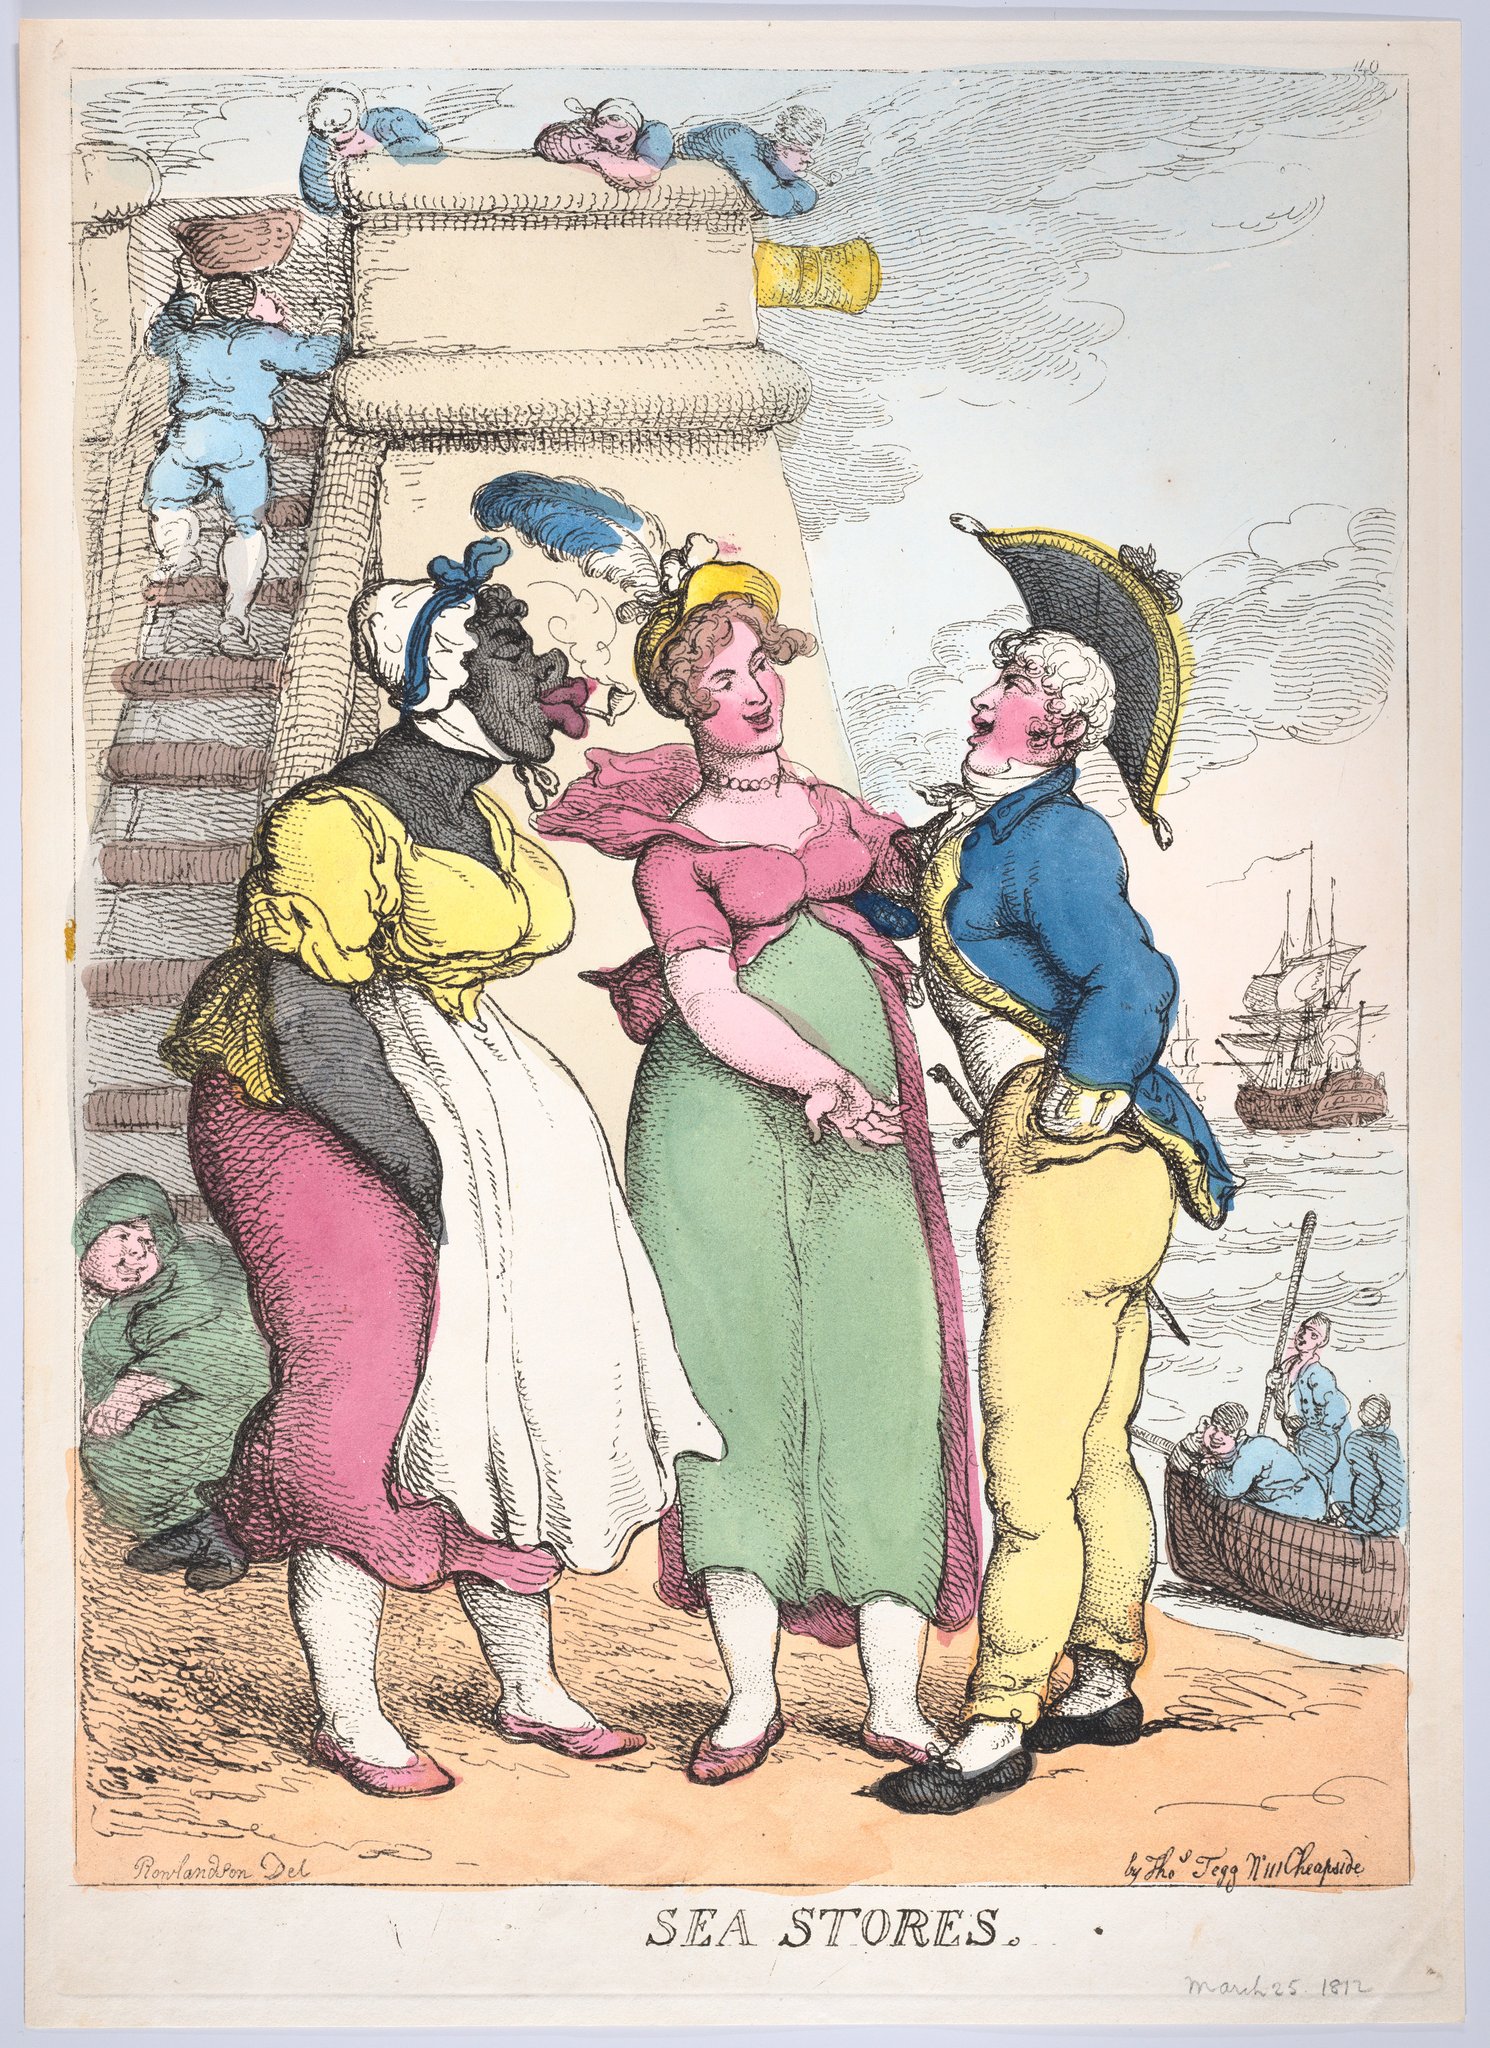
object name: print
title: Sea Stores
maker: thomas rowlandson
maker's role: artist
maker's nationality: british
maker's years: 1757-1827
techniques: etching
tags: satire,men,women,prostitutes,sailors